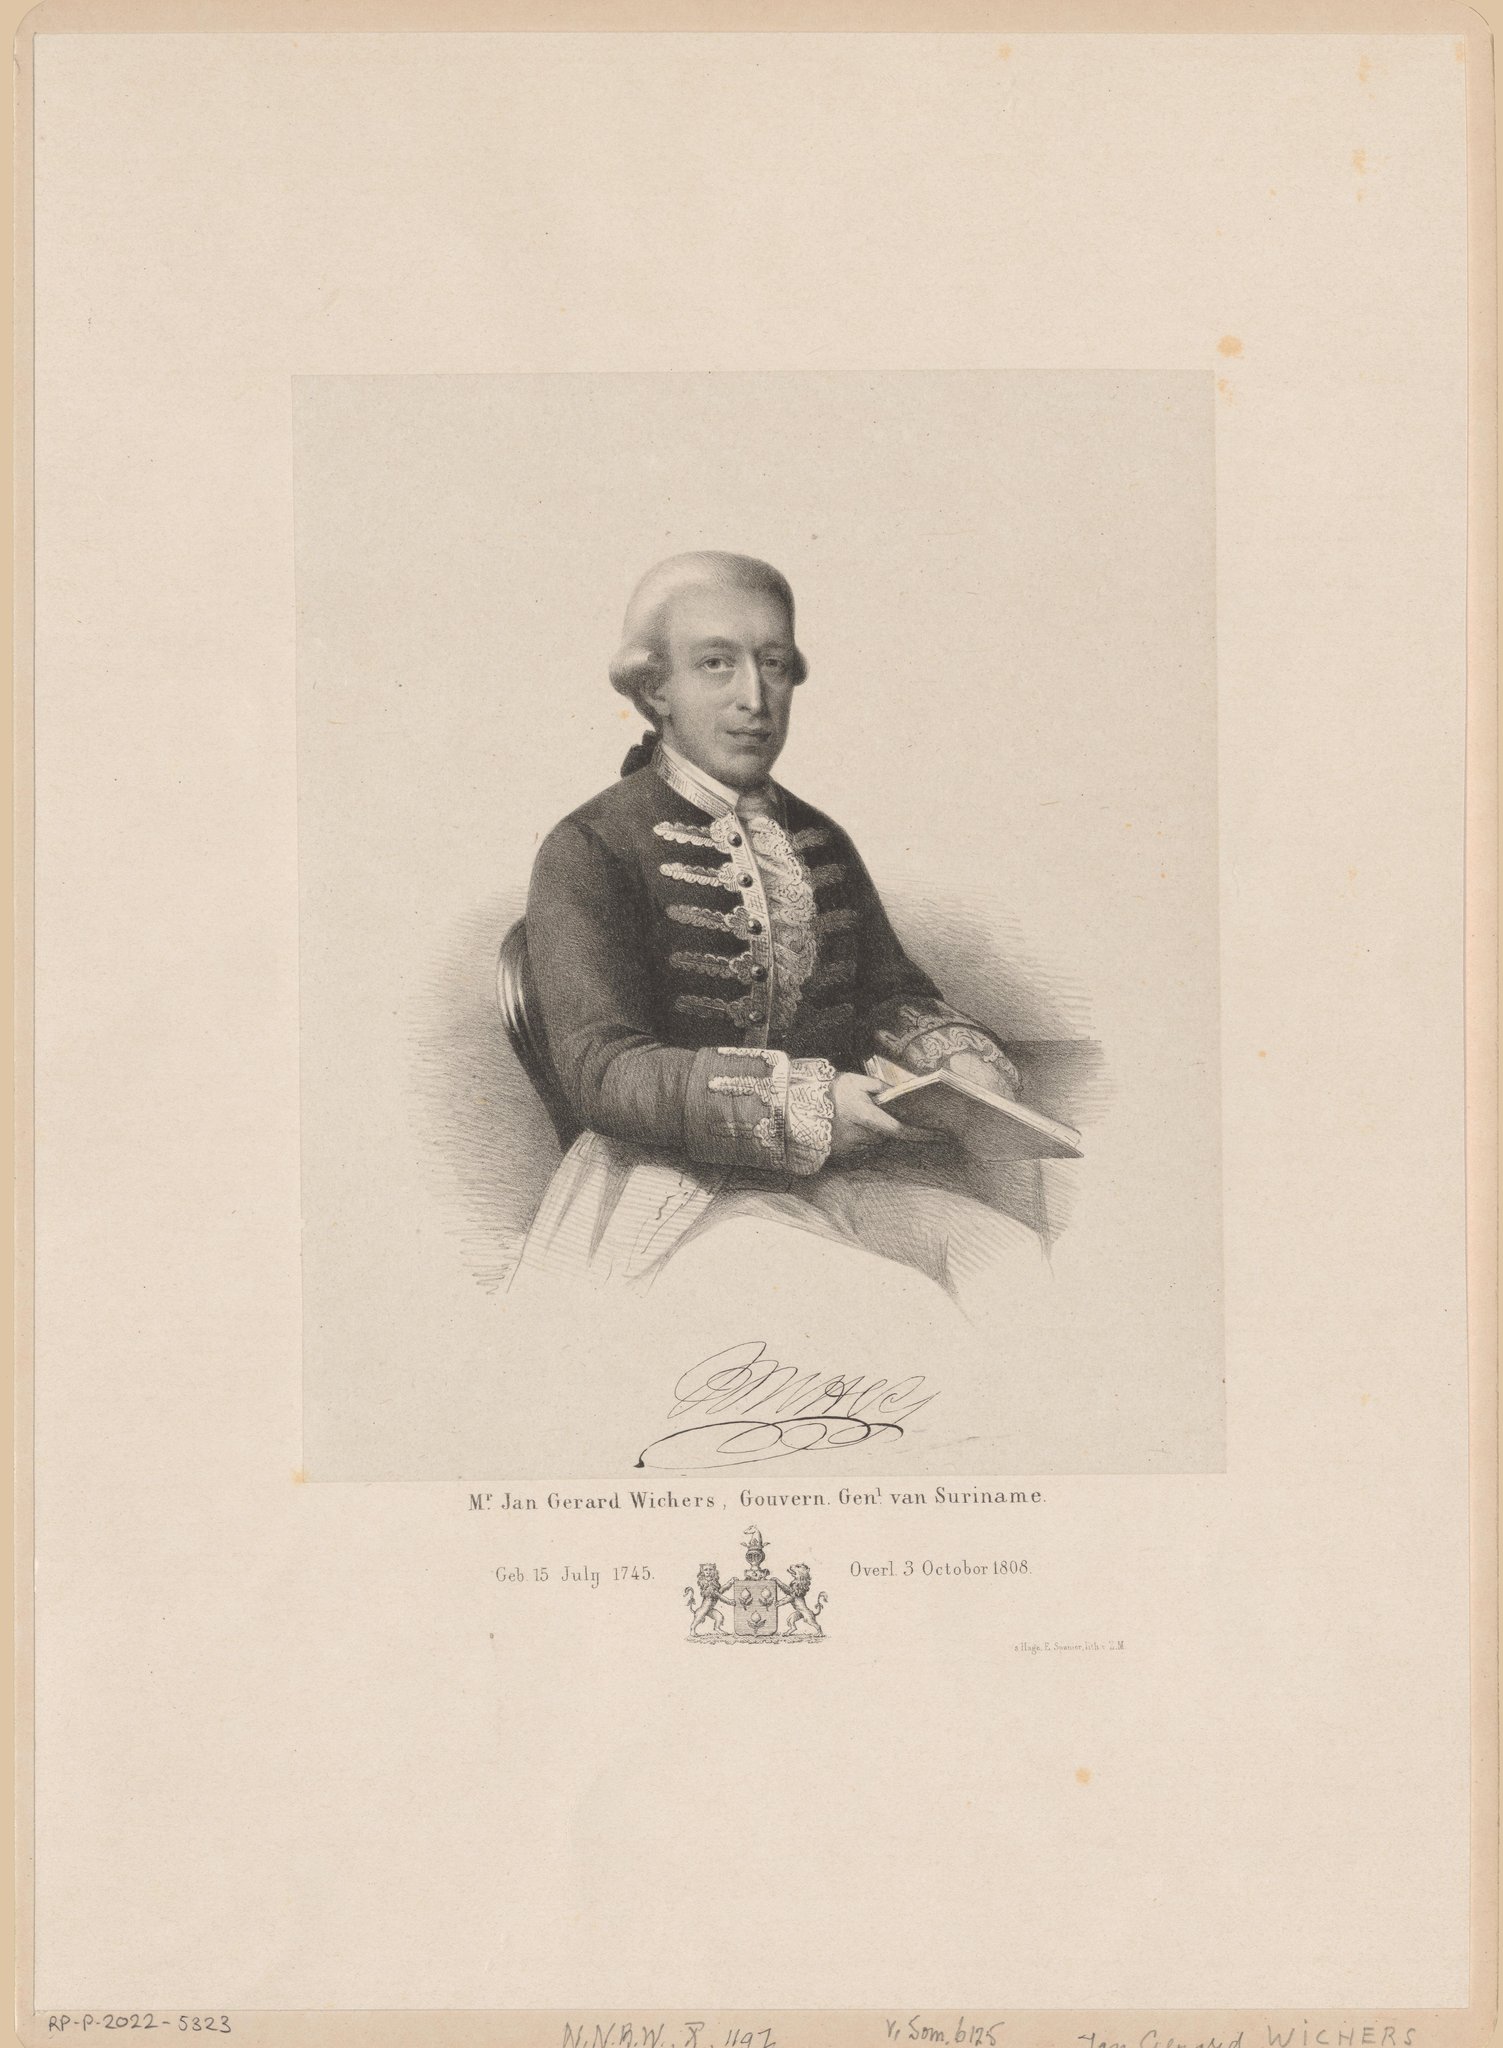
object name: print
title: Portret van Jan Gerhard Wichers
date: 1843-1863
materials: paper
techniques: lithograph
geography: netherlands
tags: groningen (province), politician, colonial governor, historical persons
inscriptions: collector's mark: Lugt 2228